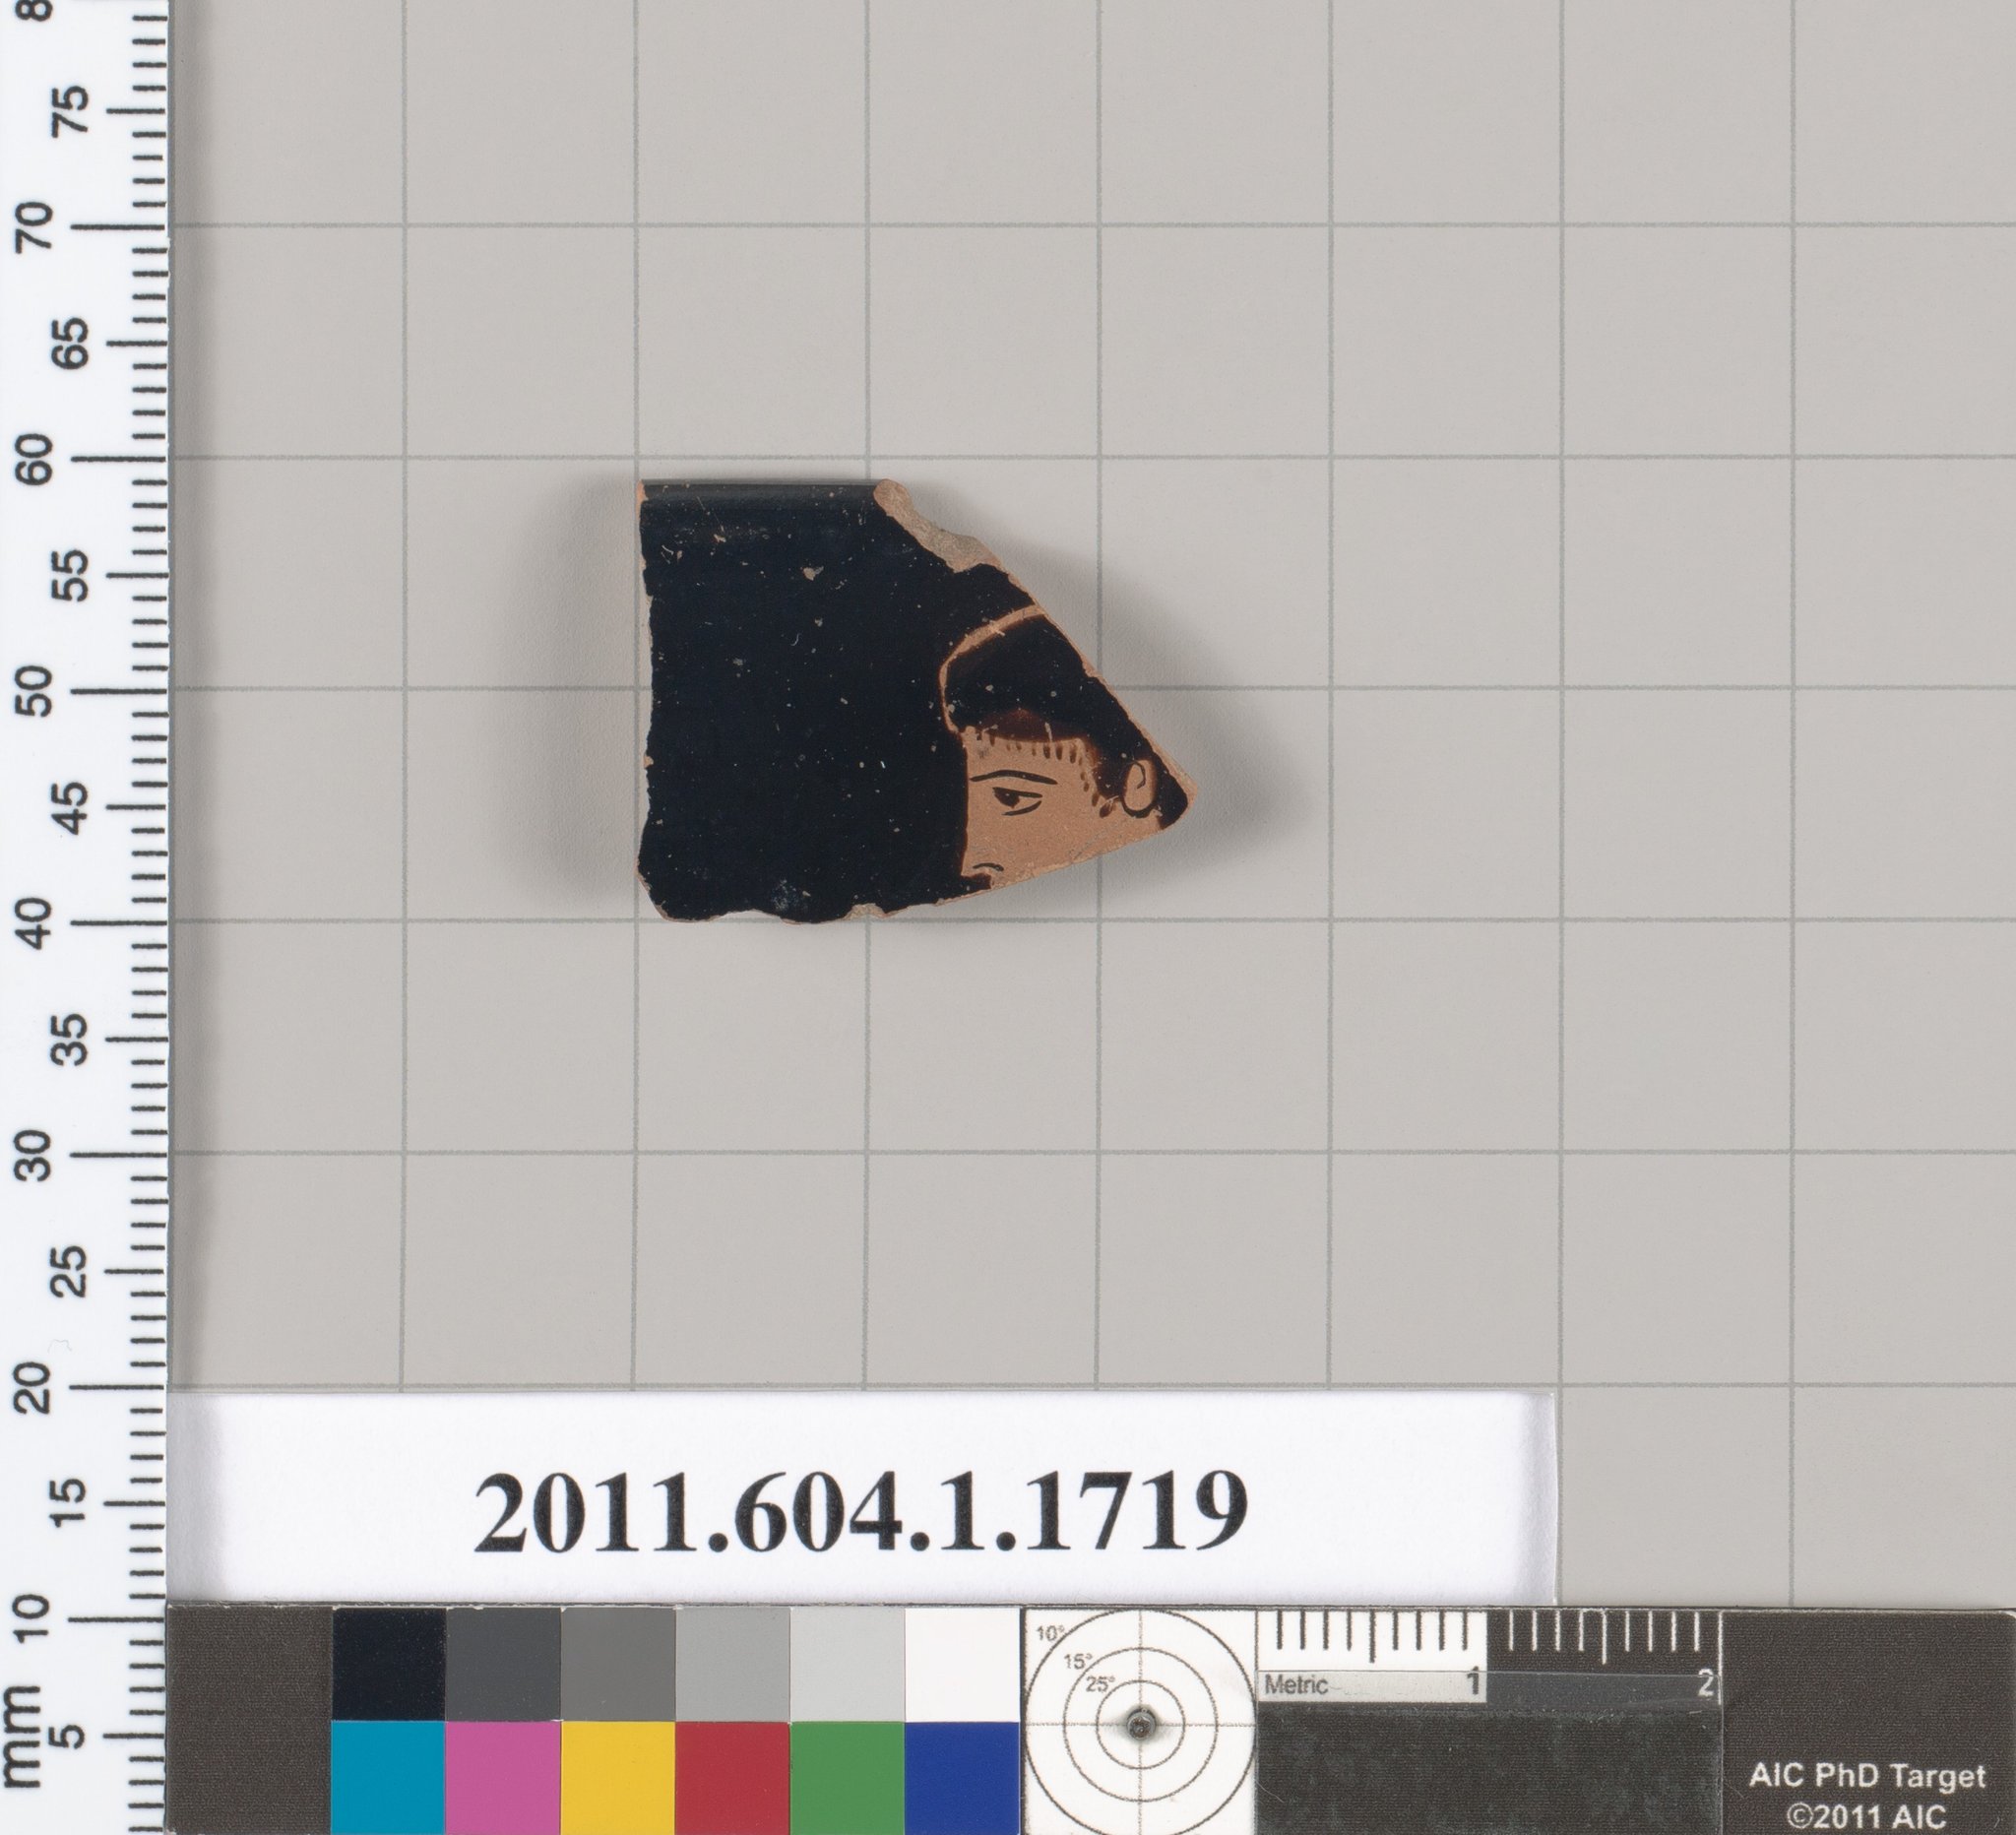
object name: kylix fragment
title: Terracotta rim fragment of a kylix (drinking cup)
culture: greek, attic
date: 475-451 BCE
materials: terracotta